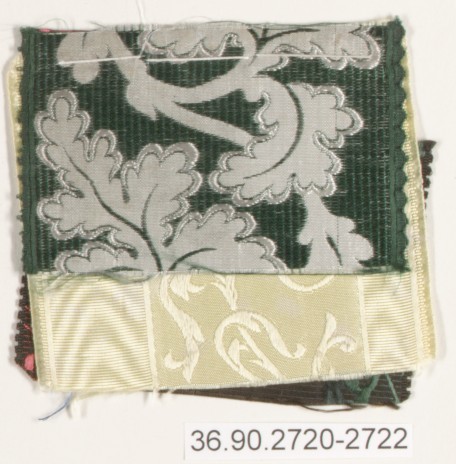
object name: ribbon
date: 1801-1900